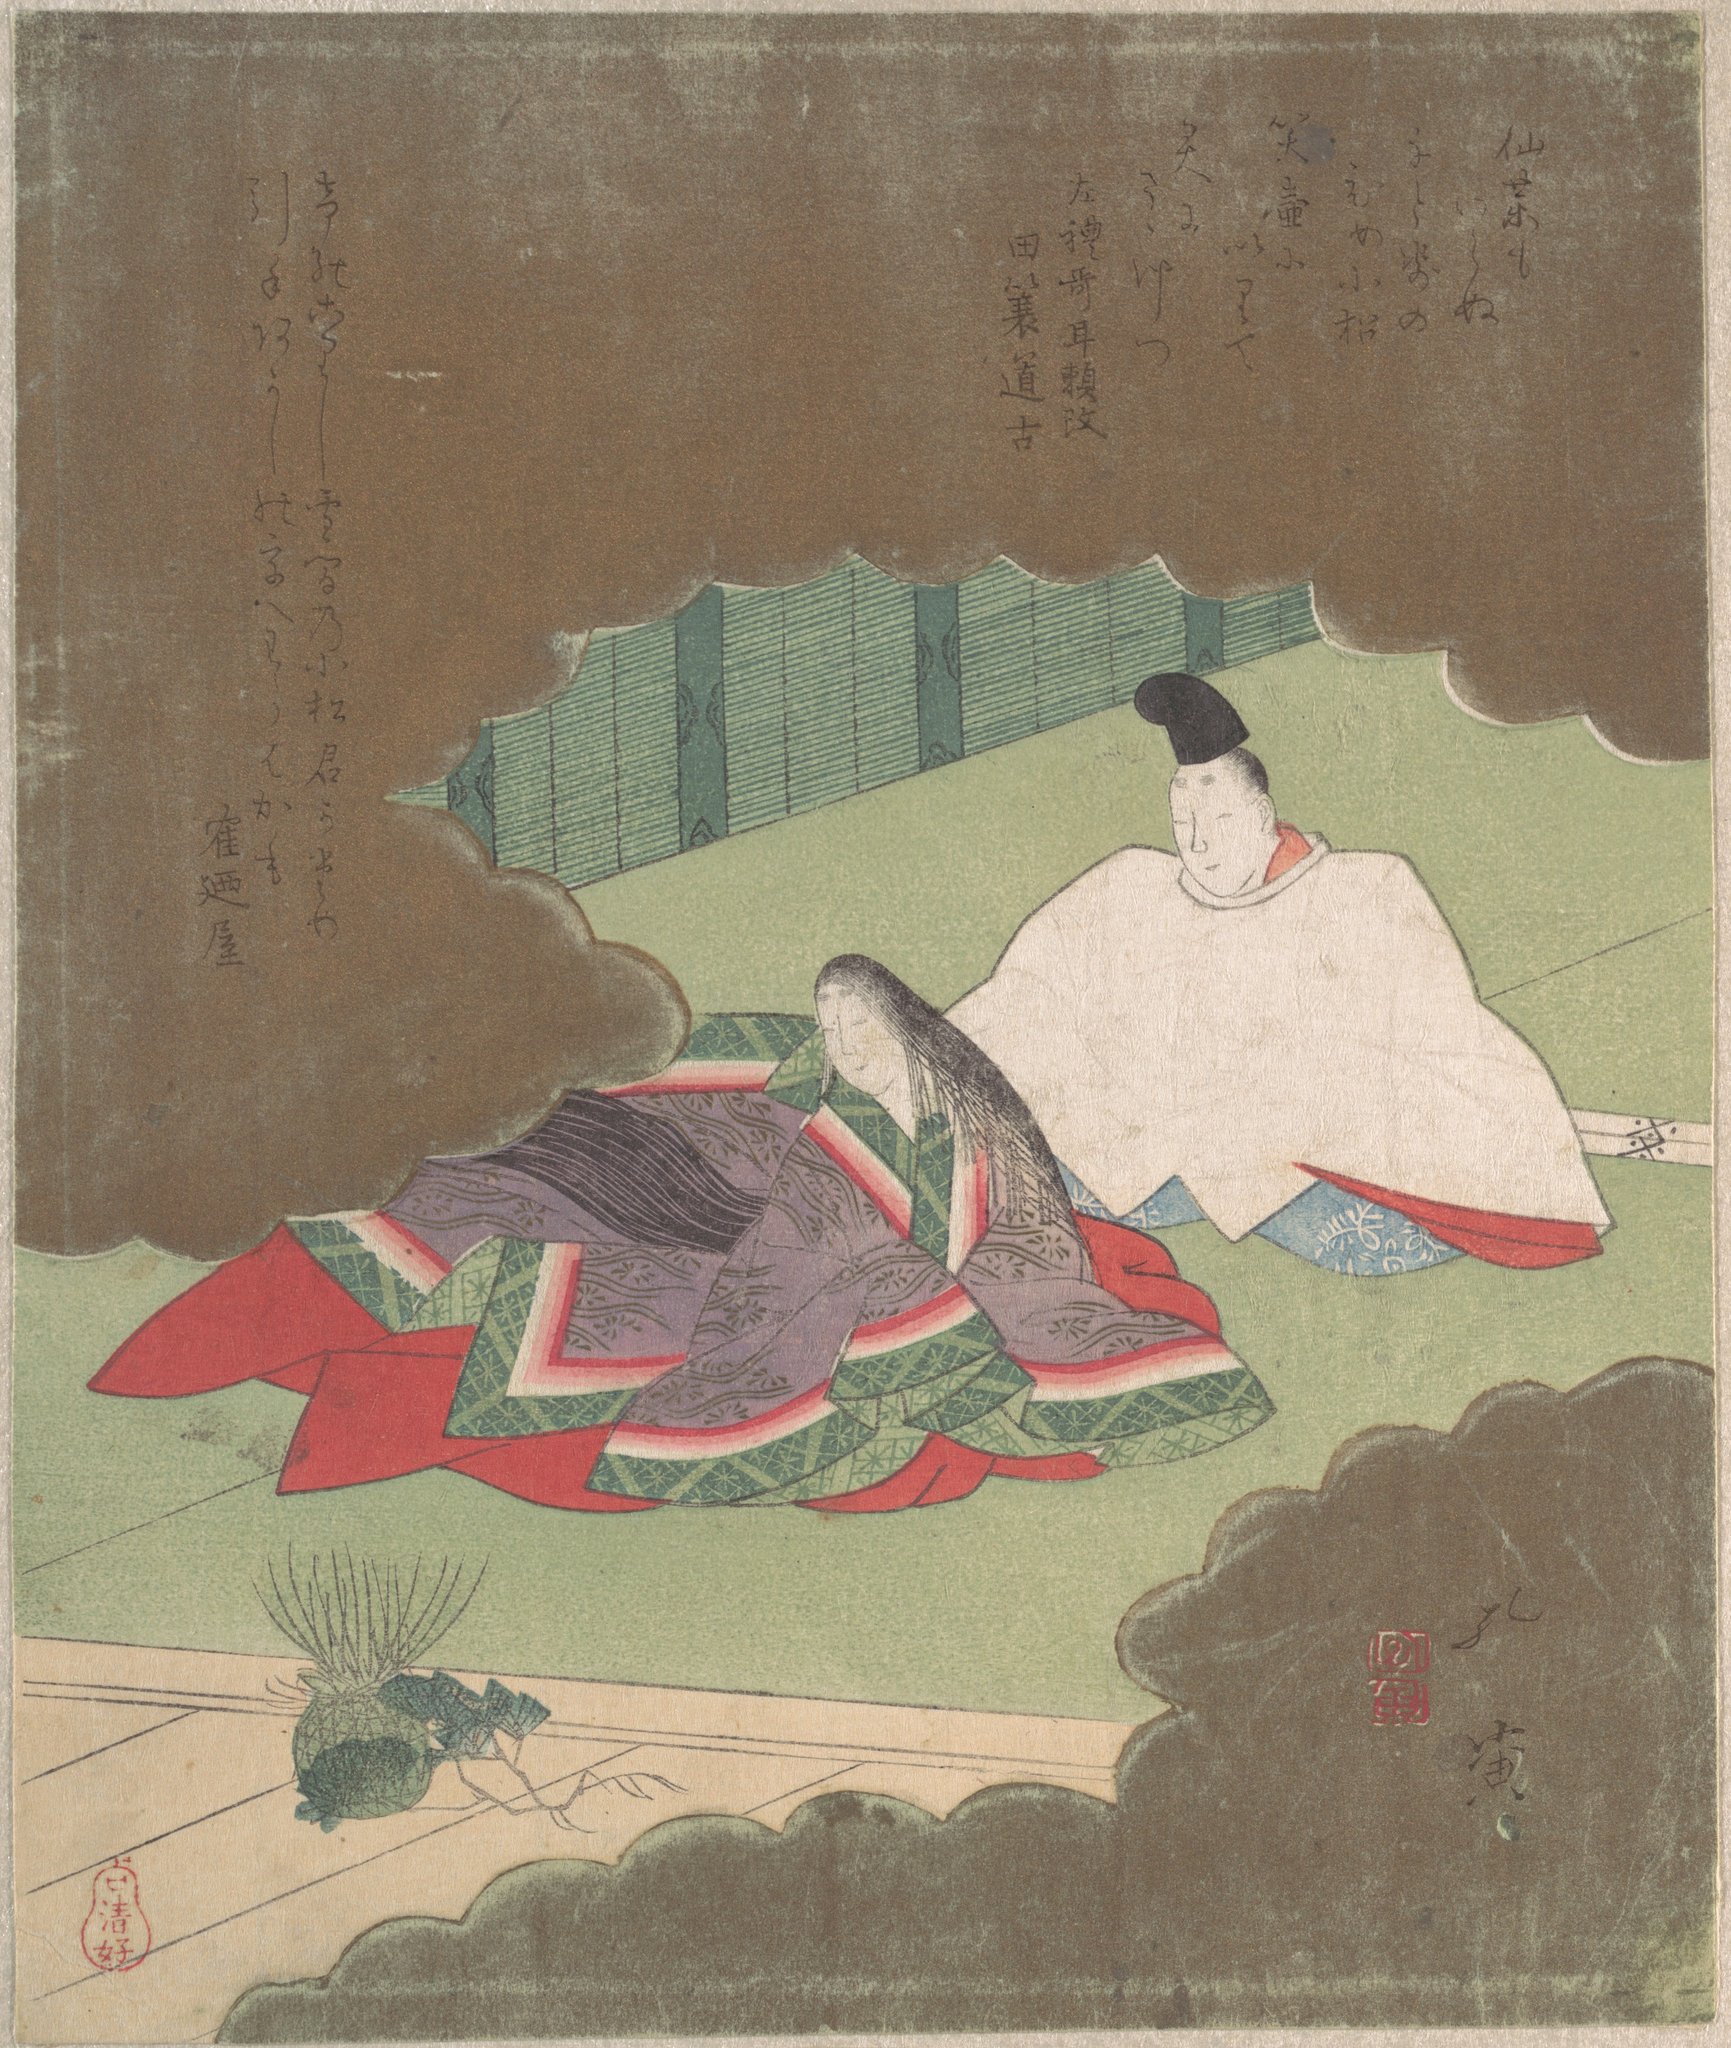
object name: print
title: Man and Woman in Court Dress Looking at Young Pines for New Year Ceremony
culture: japanese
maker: nagayama koin (hirotora)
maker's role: artist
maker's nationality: japanese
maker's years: 1765-1849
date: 1801-1900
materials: ink, paper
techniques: surimono, woodblock print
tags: dresses,men,women